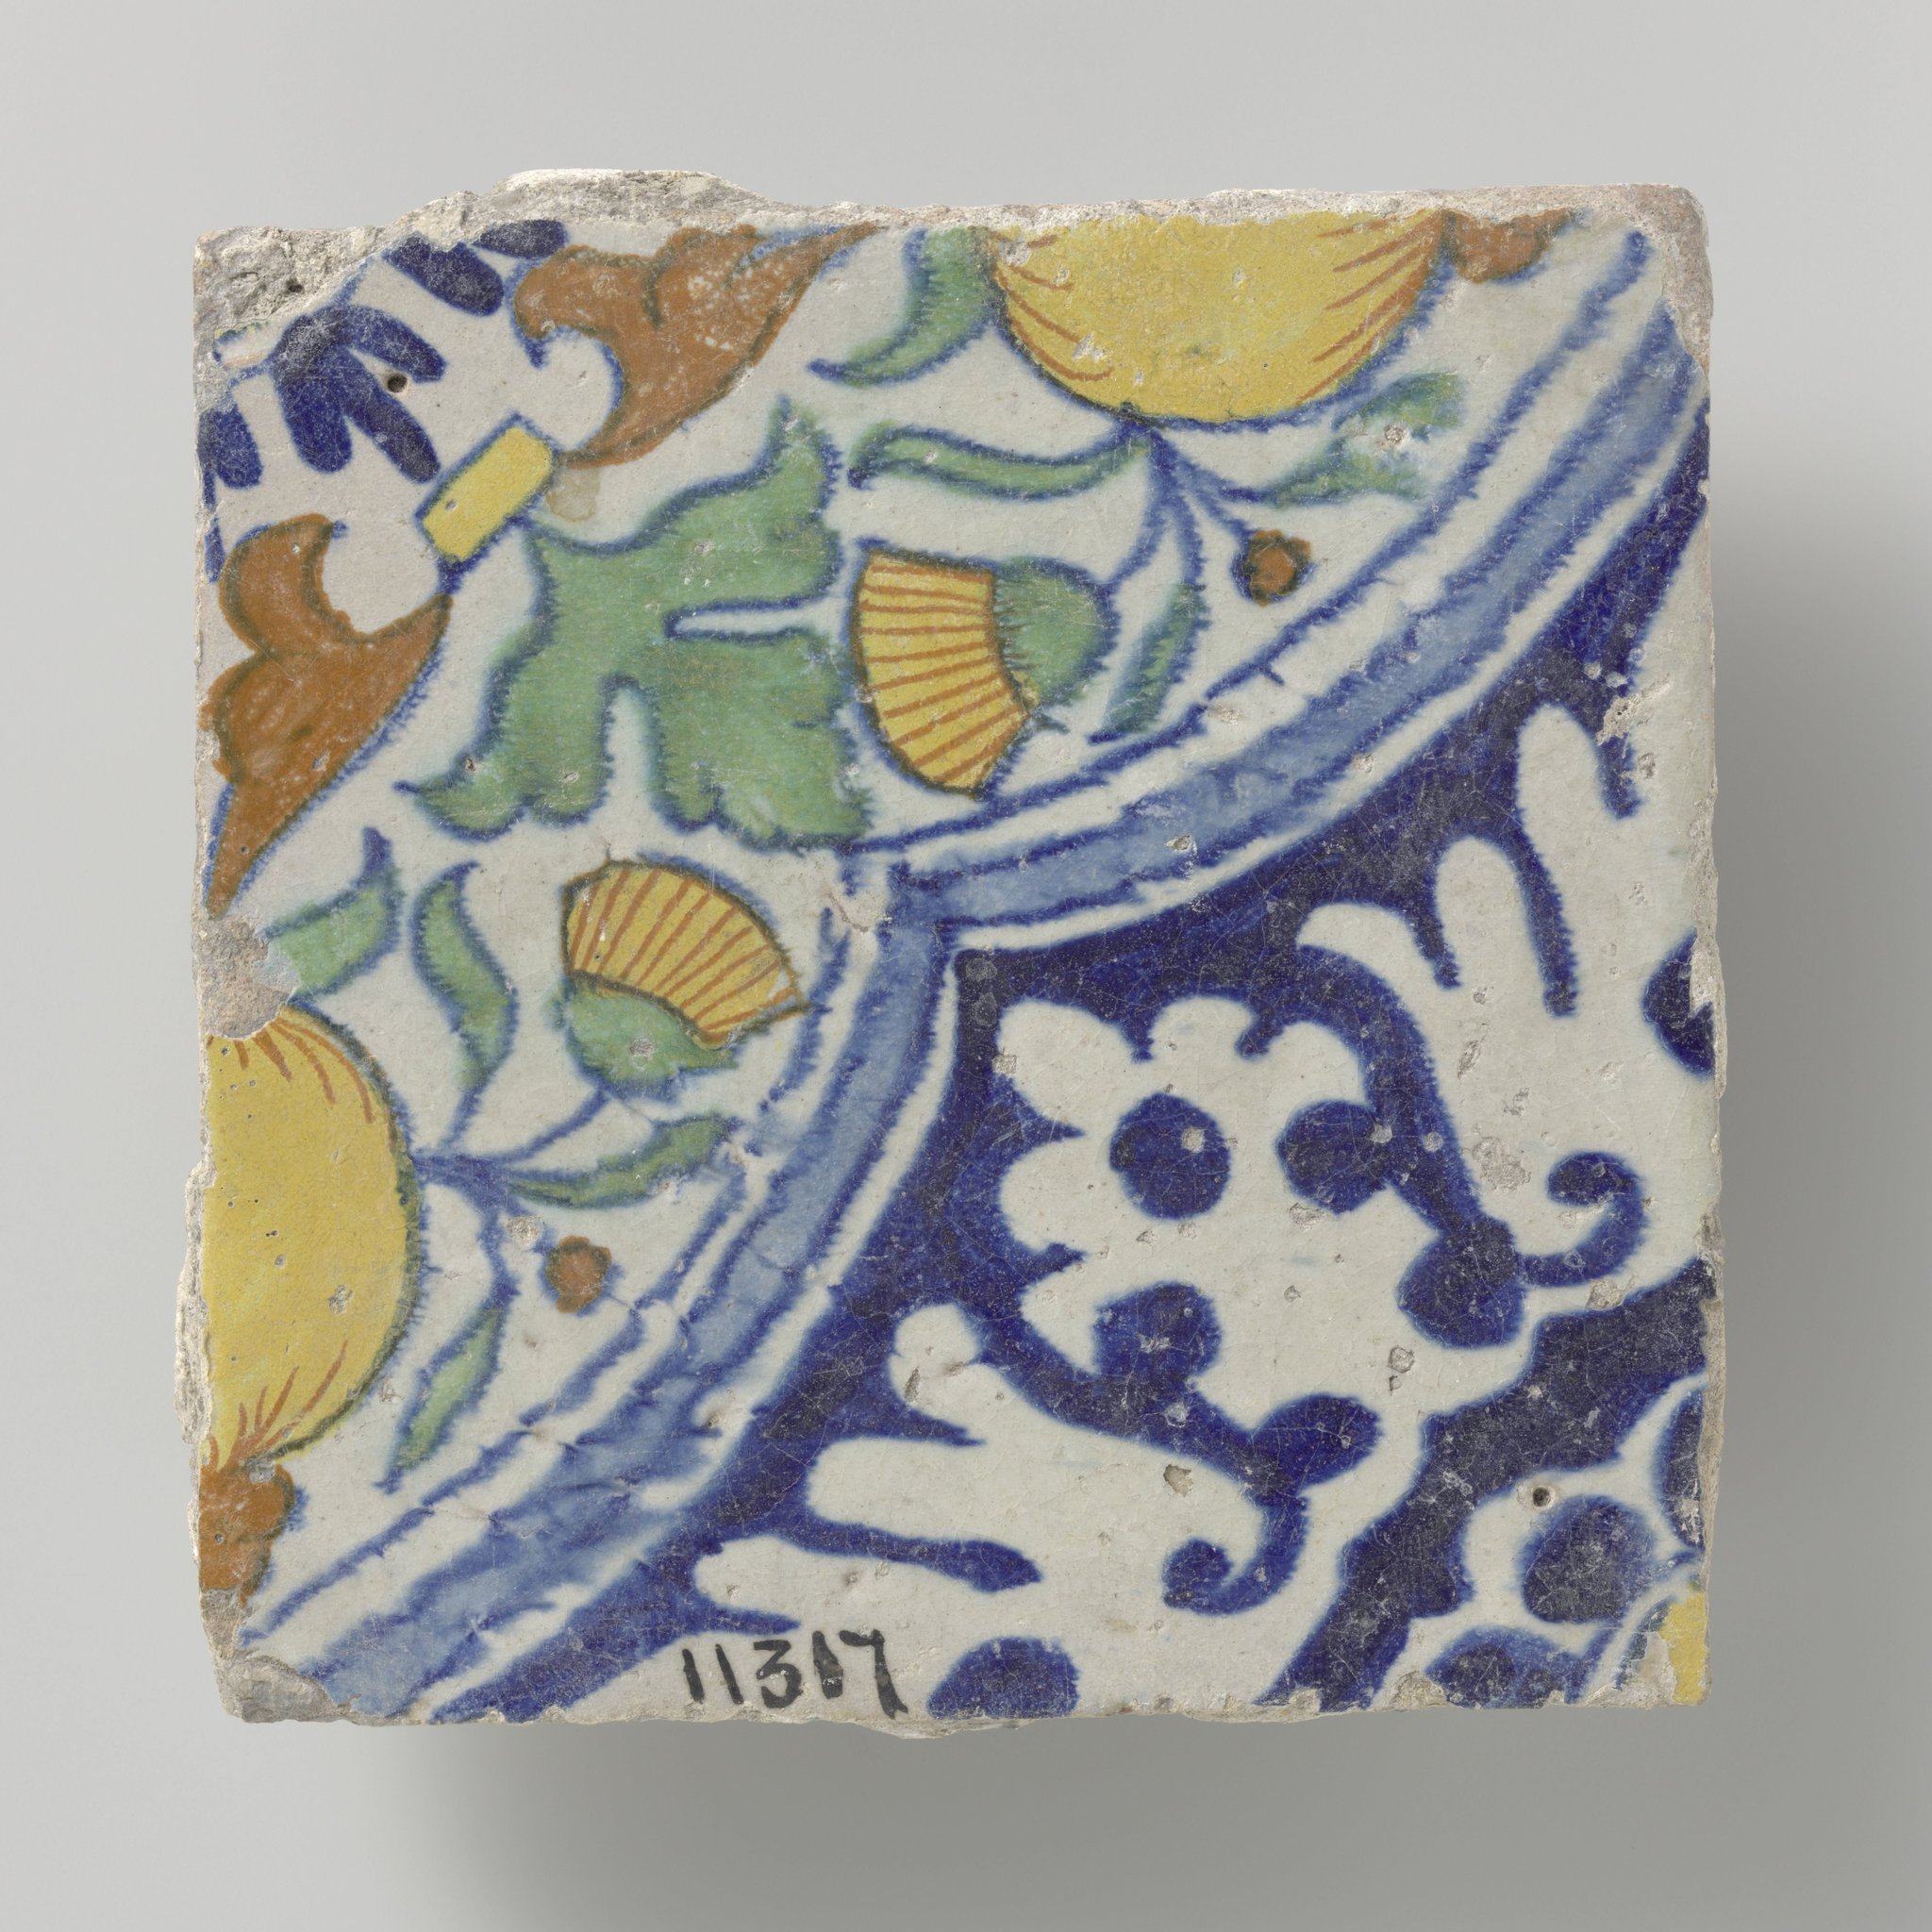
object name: tile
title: Zes tegels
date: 1599-1699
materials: earthenware, glaze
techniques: maiolica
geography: netherlands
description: Zes veelkleurige tegels waarvan 4 met hetzelfde ornament en de 2 overige verschillend.